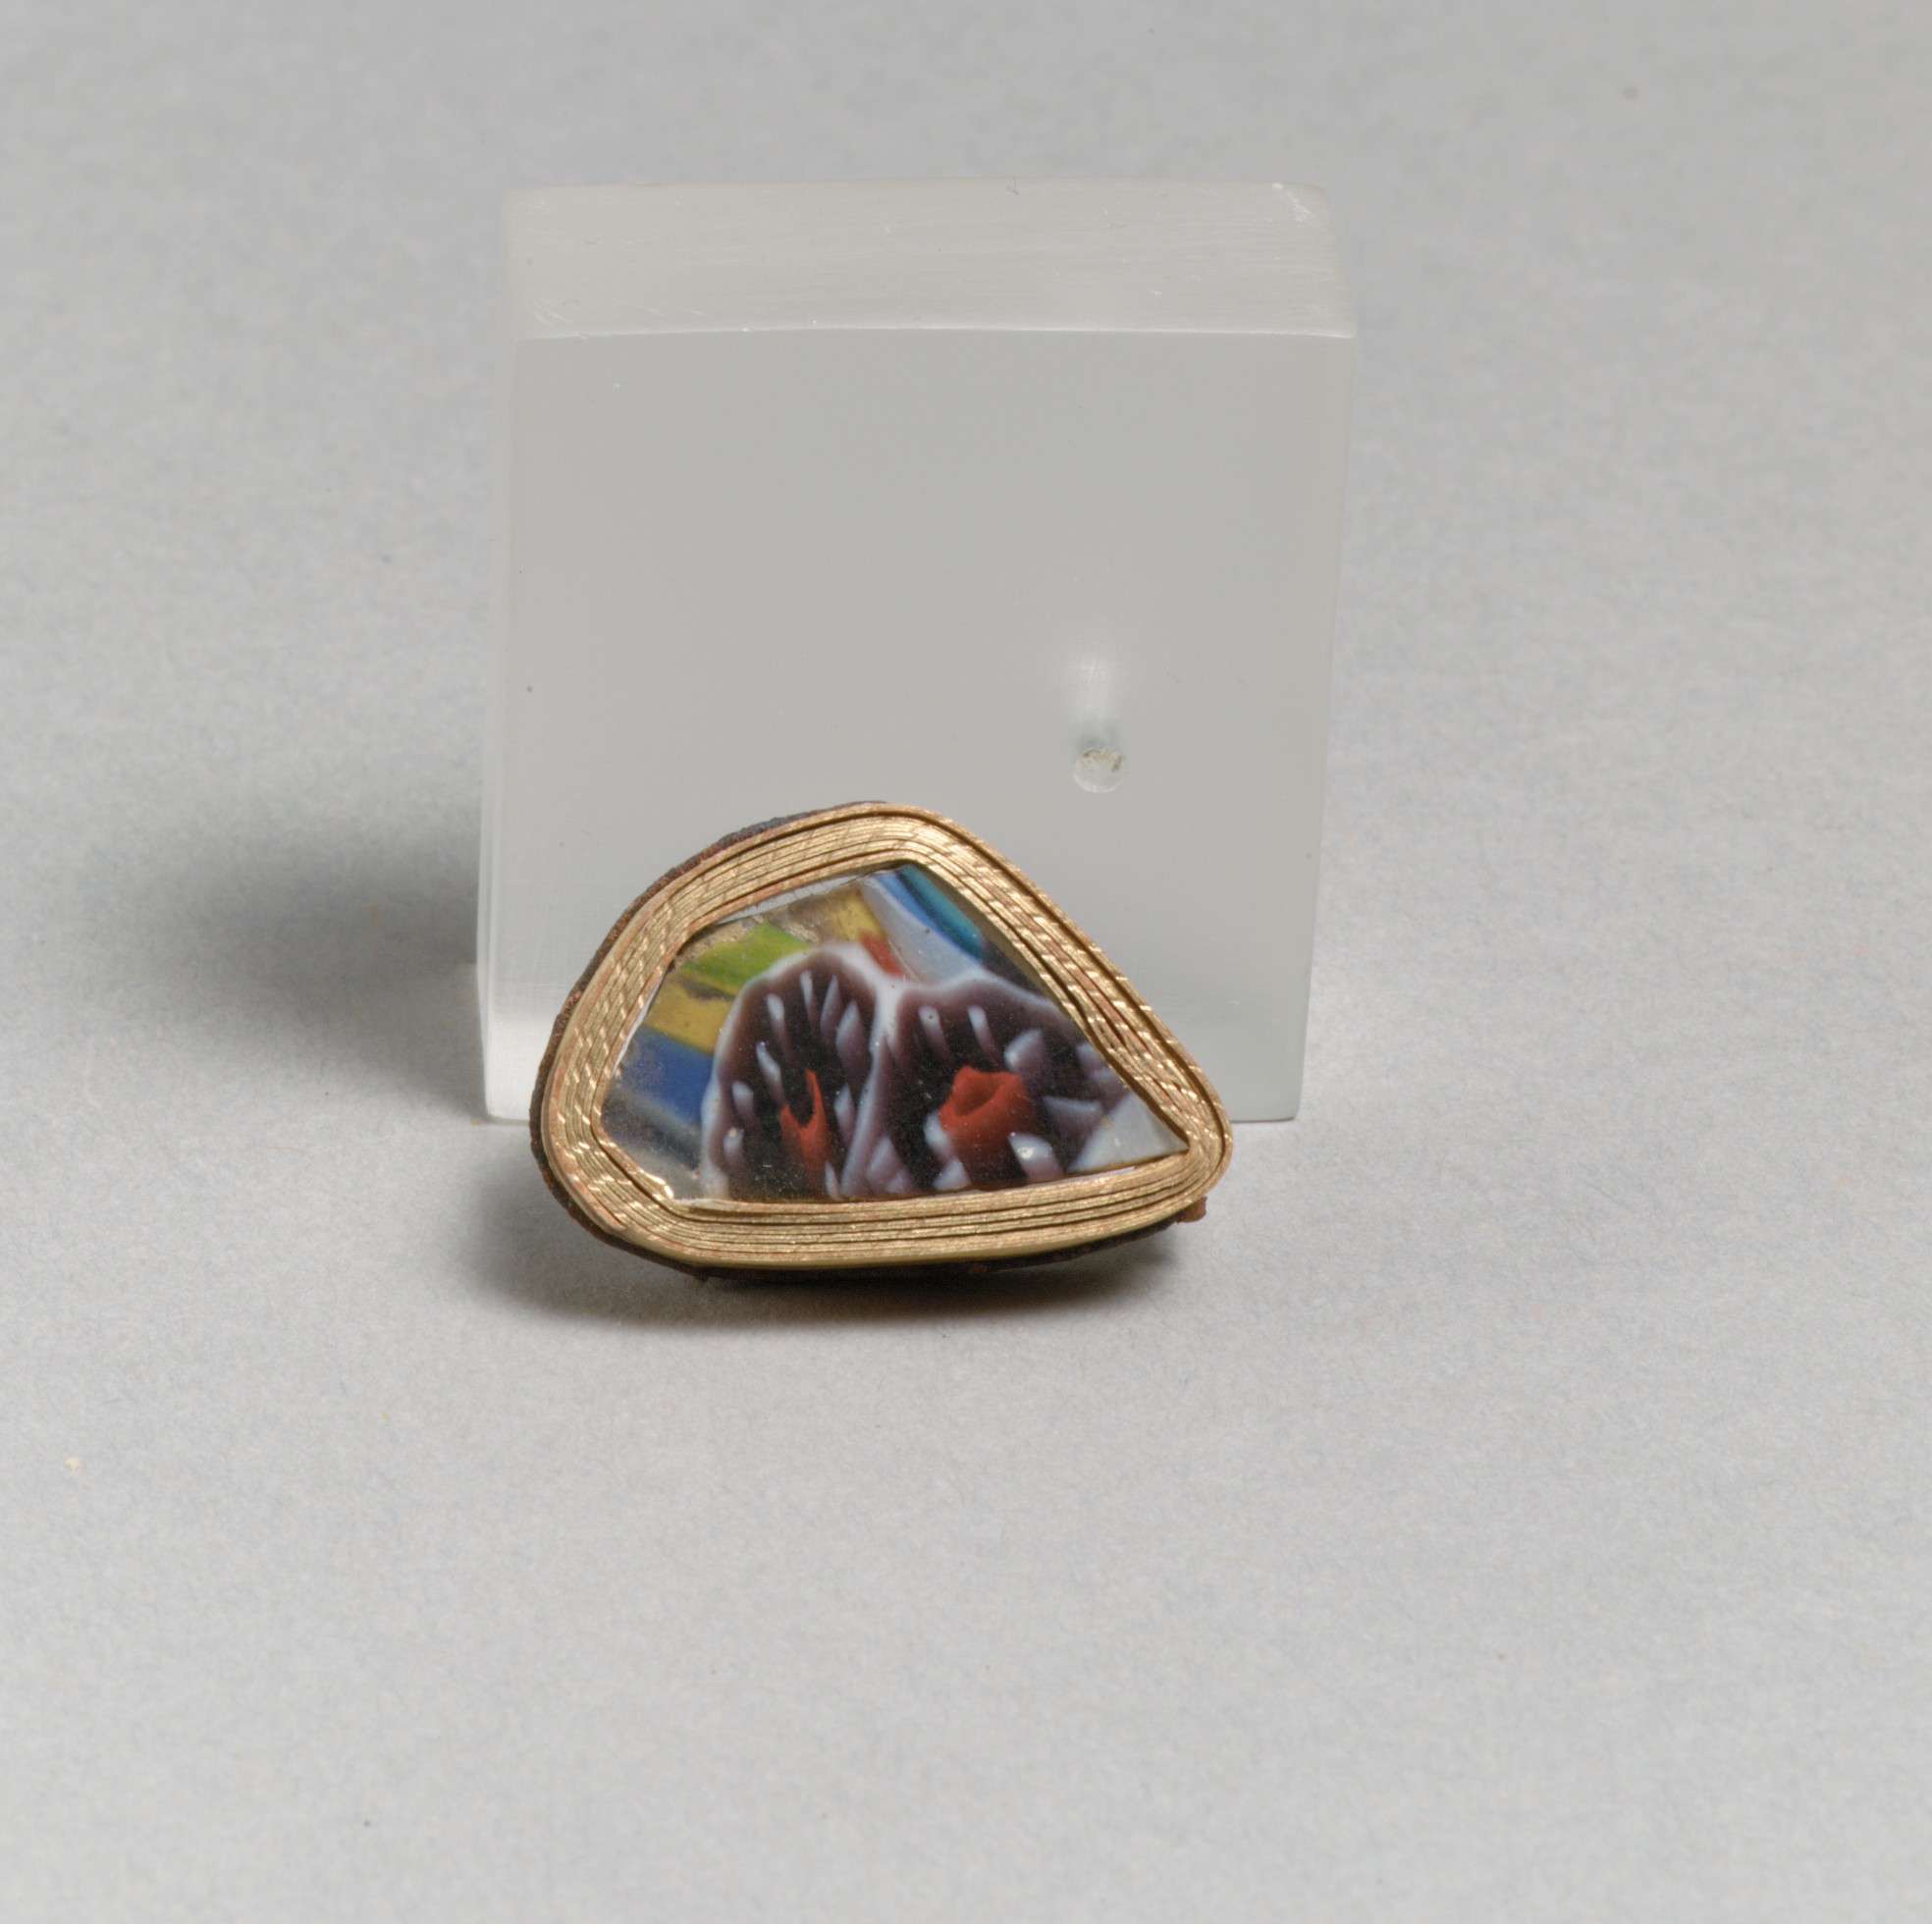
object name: fragment, short strip mosaic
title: Glass short-strip mosaic fragment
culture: roman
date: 34 BCE-33 CE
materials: glass